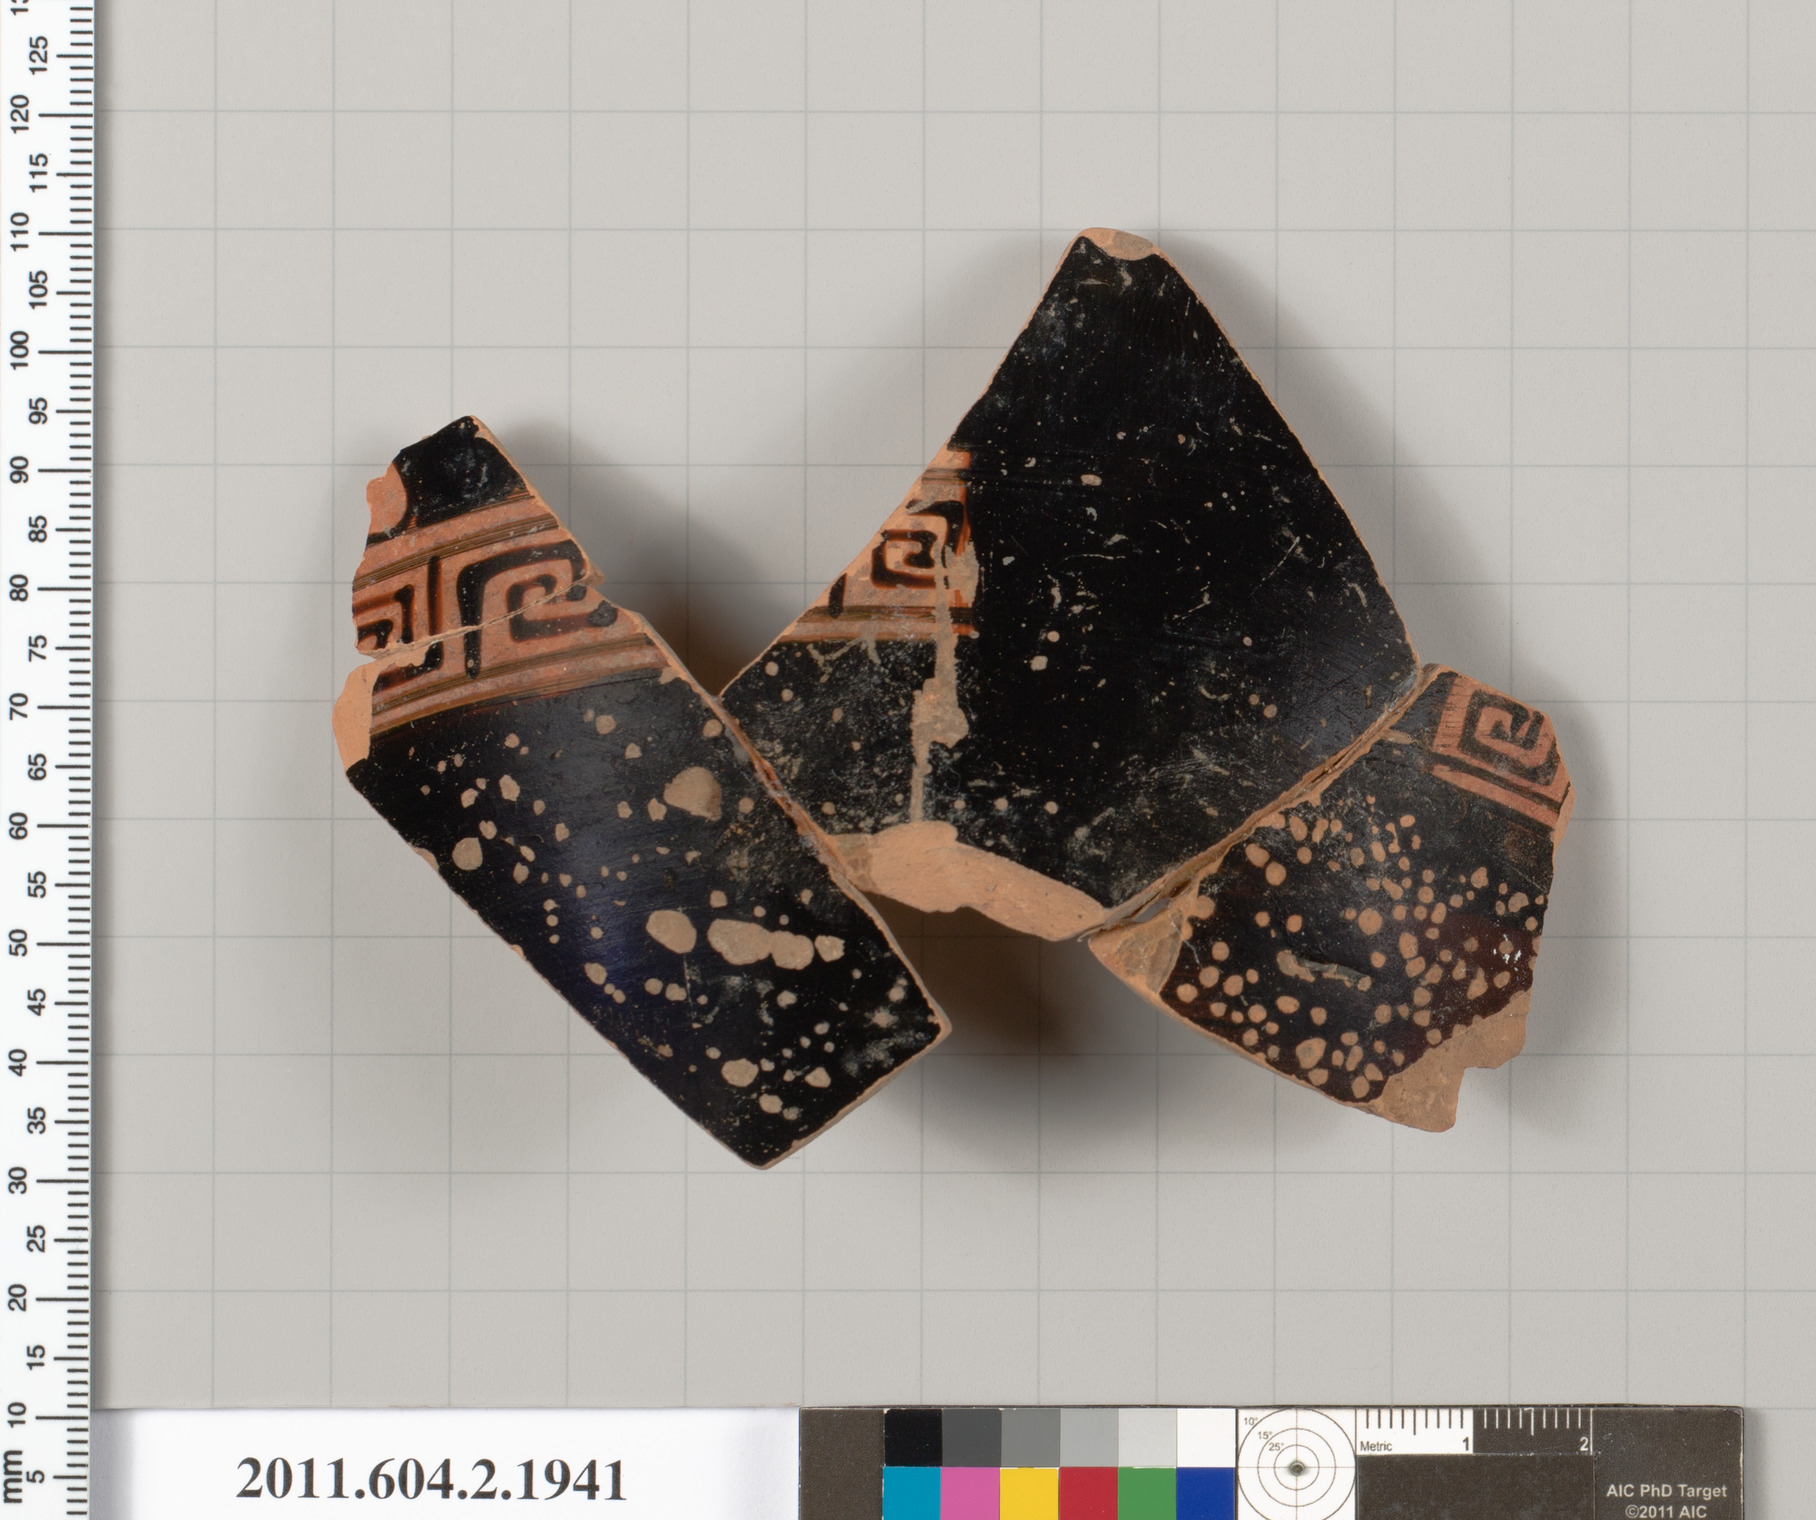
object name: neck amphora fragment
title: Terracotta fragment of a Nolan neck-amphora (jar)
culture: greek, attic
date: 475-460 BCE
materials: terracotta